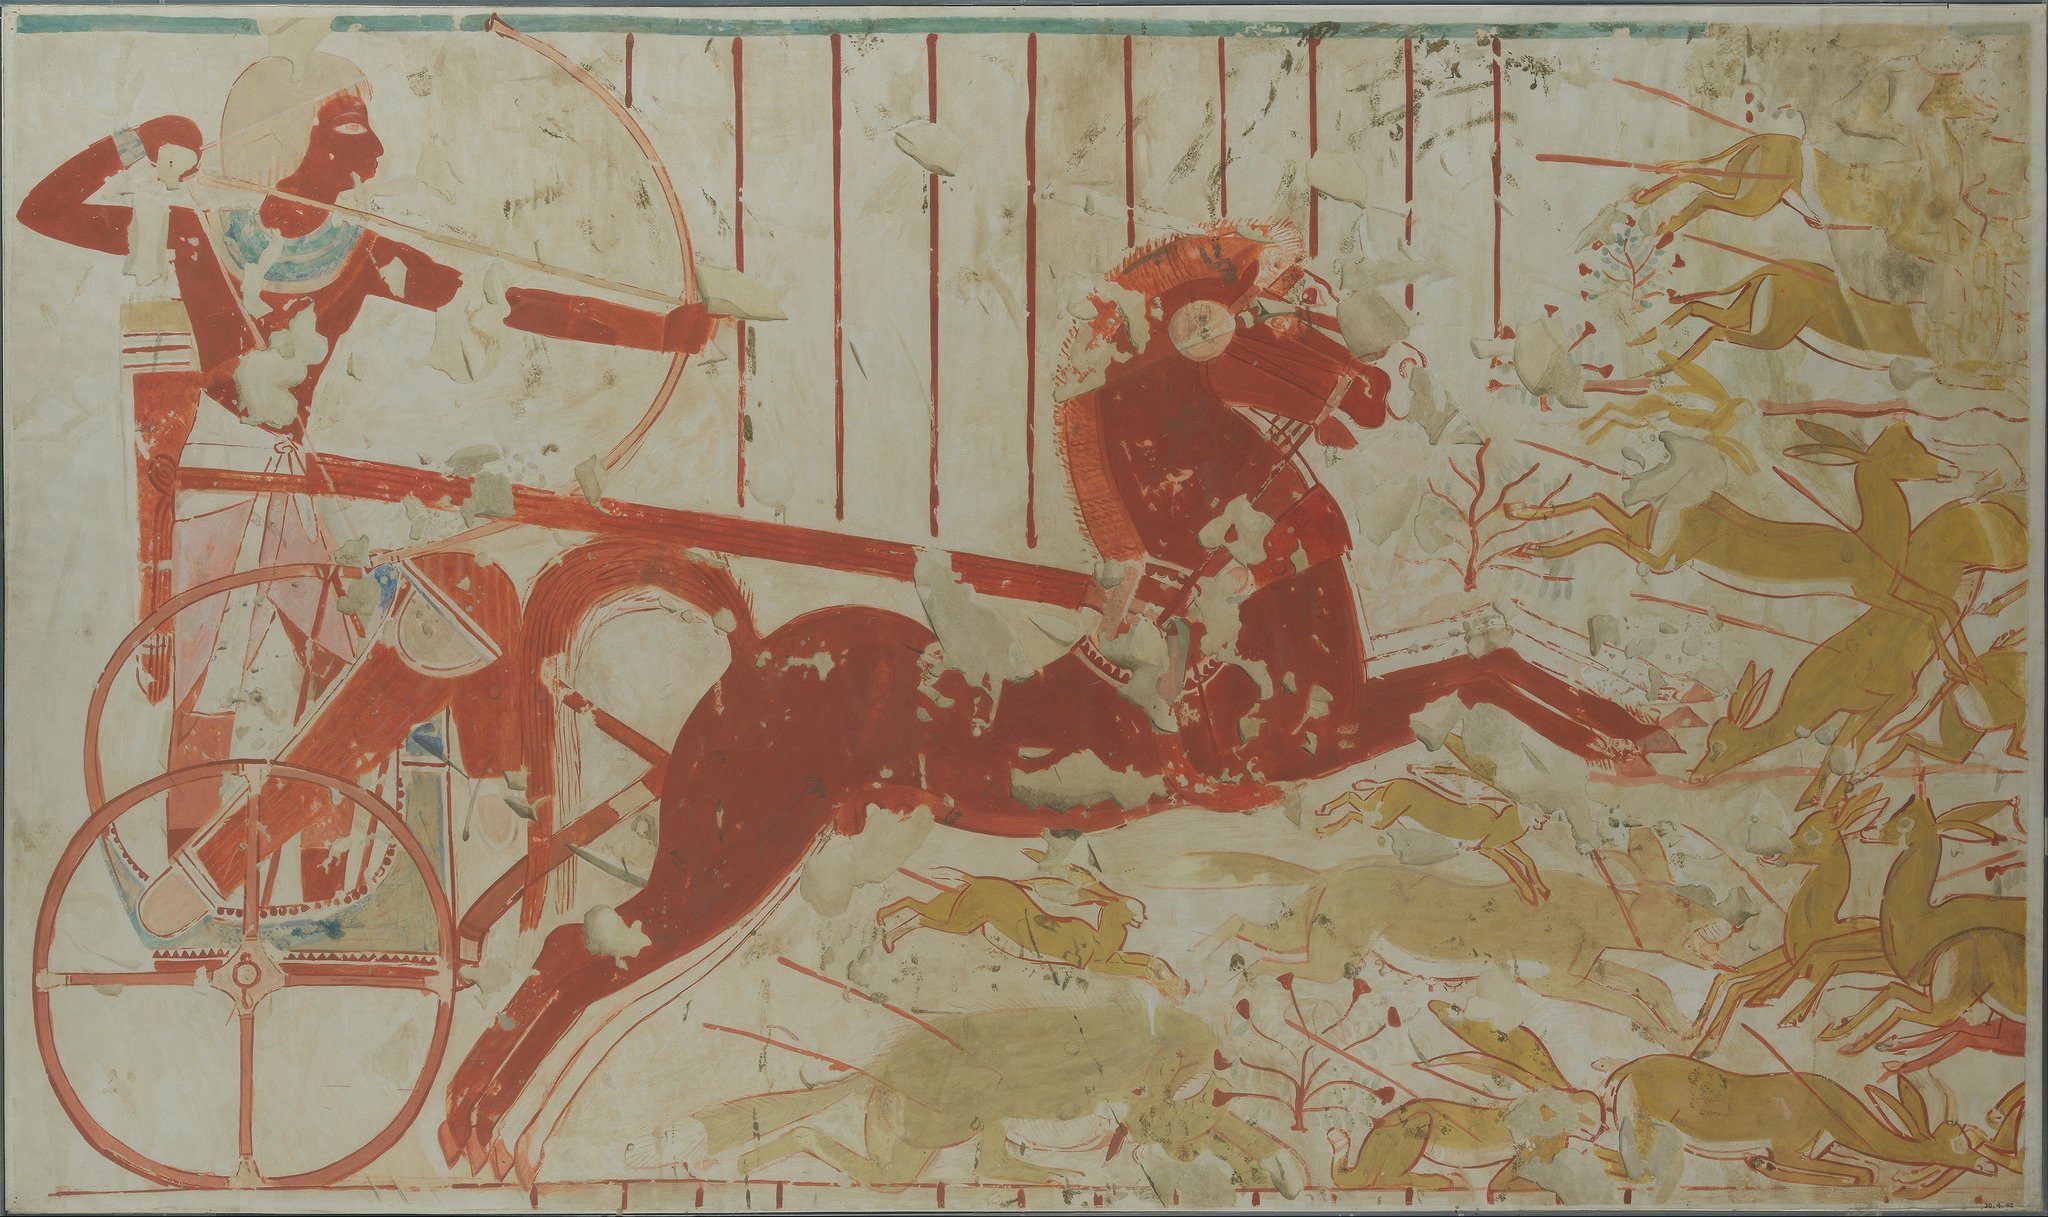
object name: facsimile, userhat tt 56, hunting, chariot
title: Hunting from a Chariot, Tomb of Userhat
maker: charles k. wilkinson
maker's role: artist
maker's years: 1897-1986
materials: paper, paint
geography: egypt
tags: bow and arrow,men,hunting,deer,horses,chariots